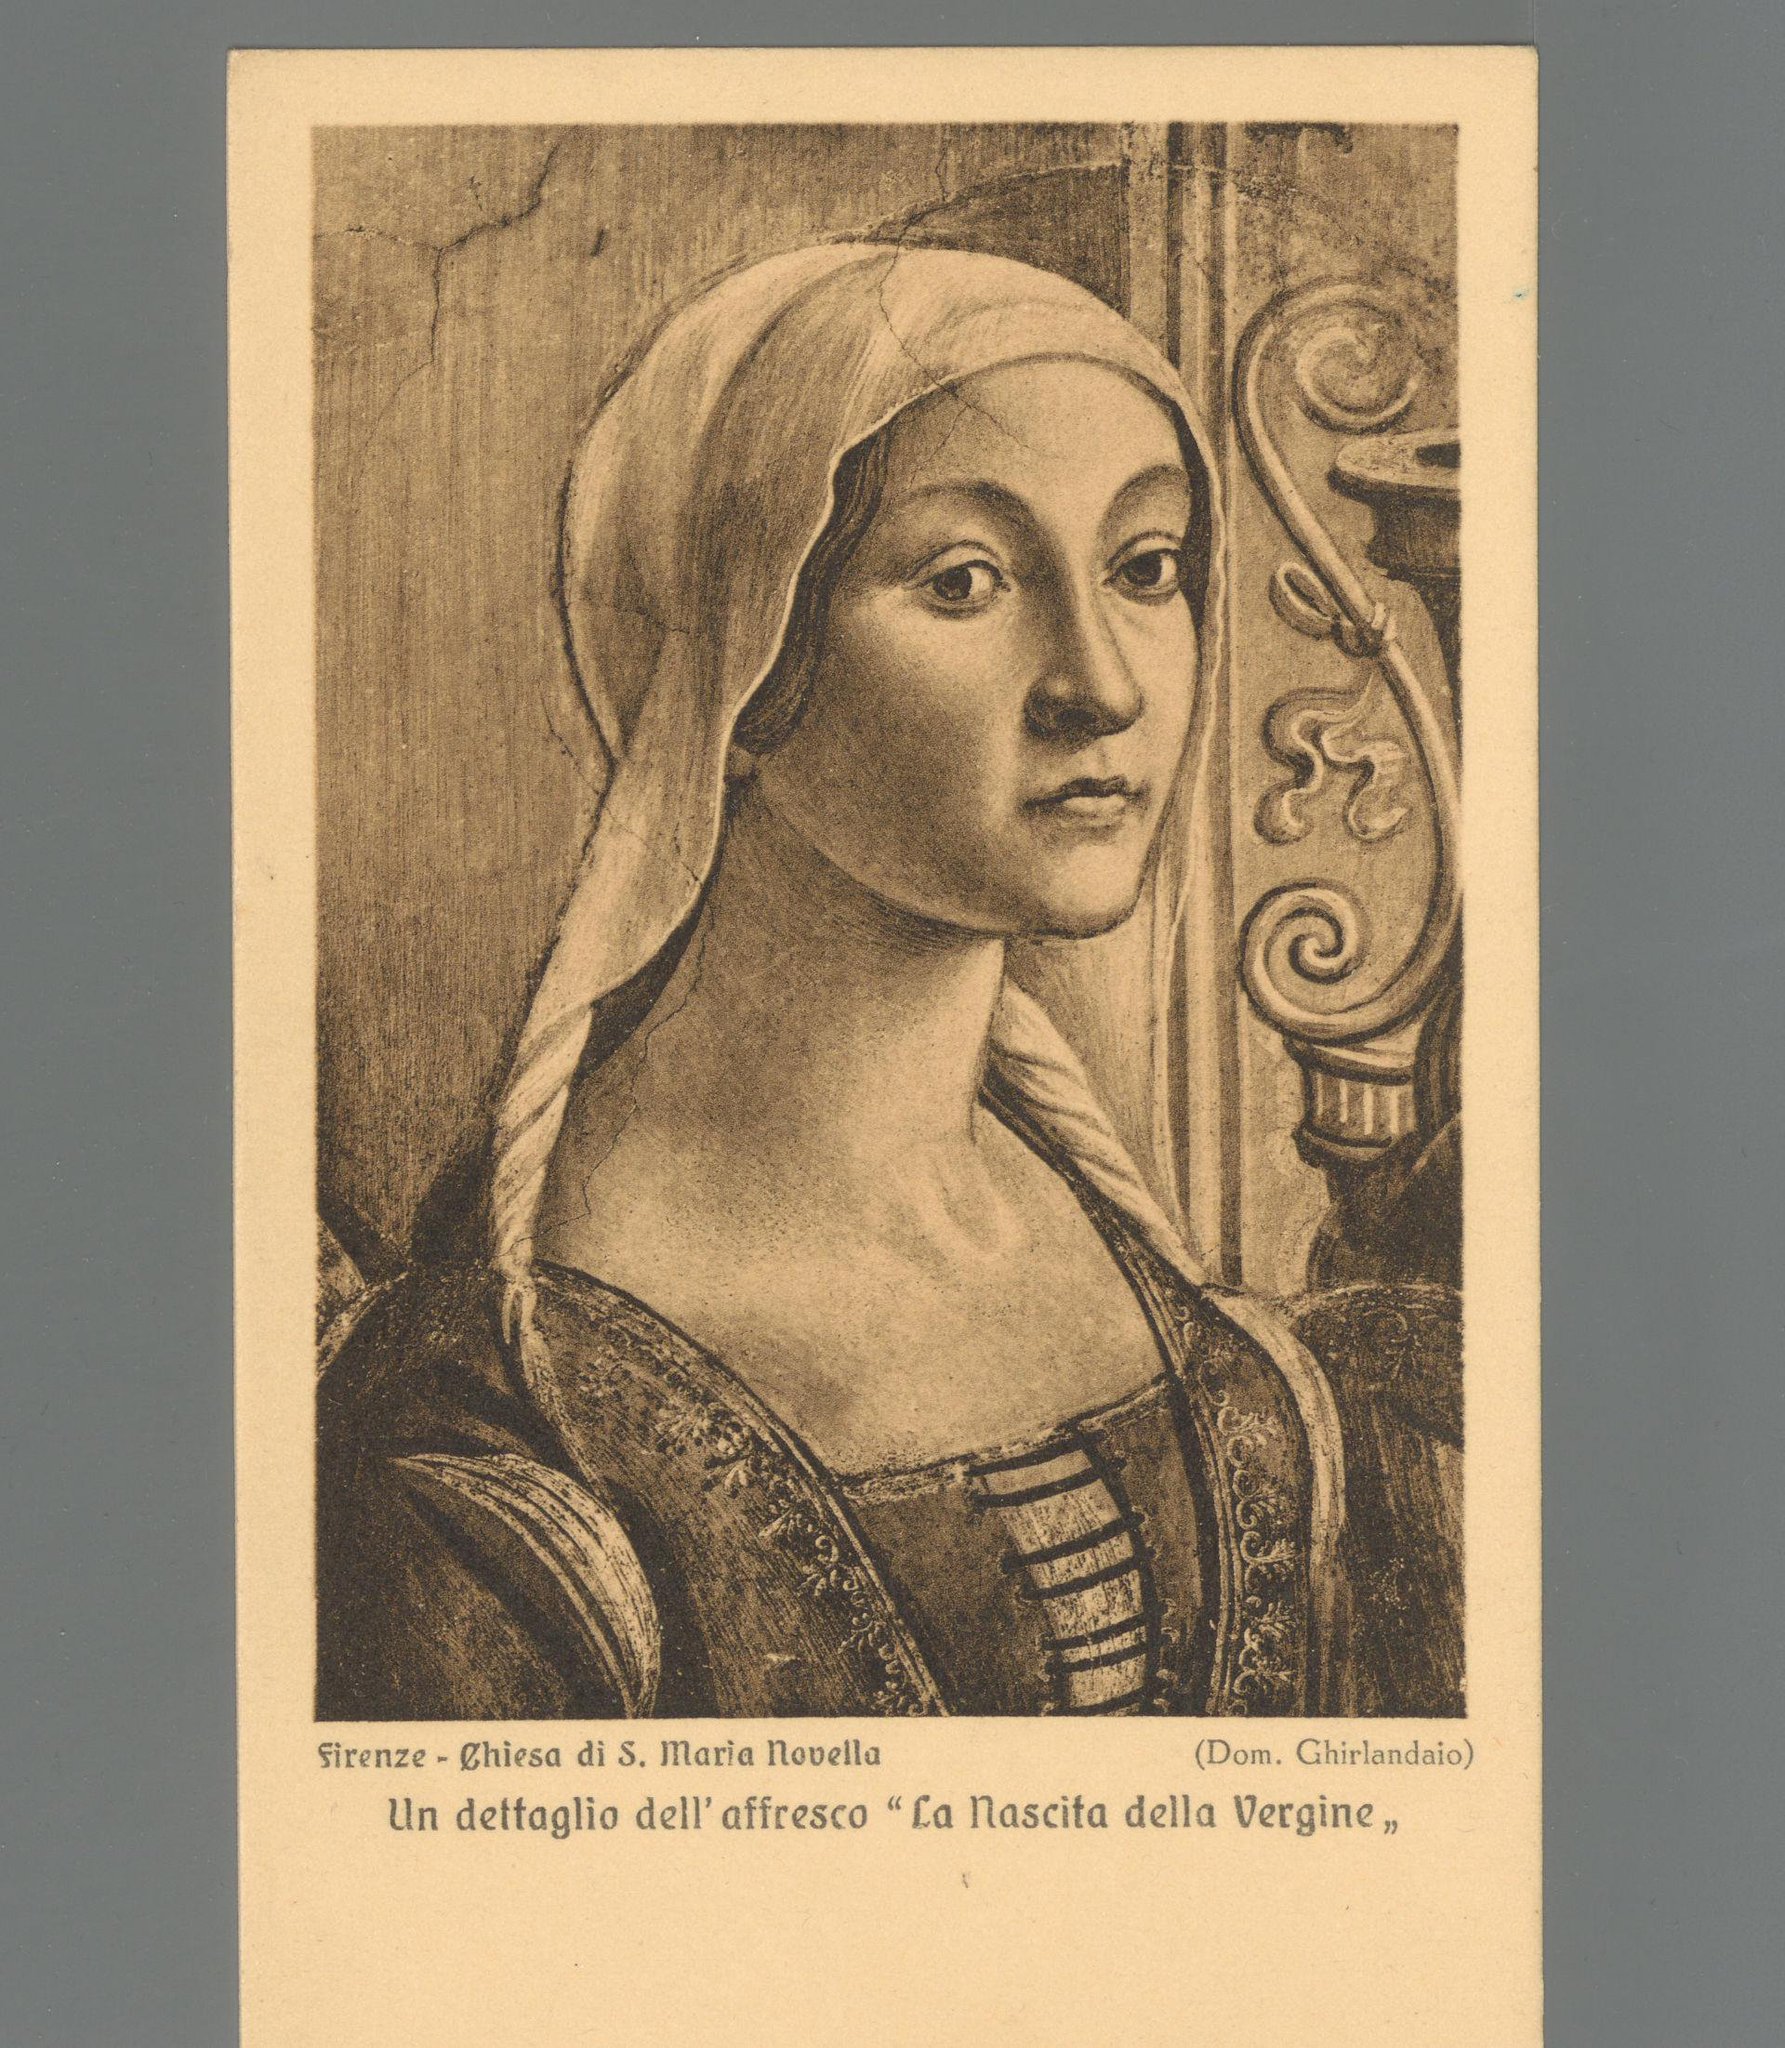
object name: ansichtkaart, prentbriefkaart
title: Firenze - Chiesa di S. Maria Novella. Un dettaglio dell' affresco "La Nascita della Vergine" (Dom. Ghirlandaio)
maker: Anonymous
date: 1906-1930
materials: cardboard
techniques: photograph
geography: florence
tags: church (exterior), picture, painting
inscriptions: collector's mark: ‘AFE v S’